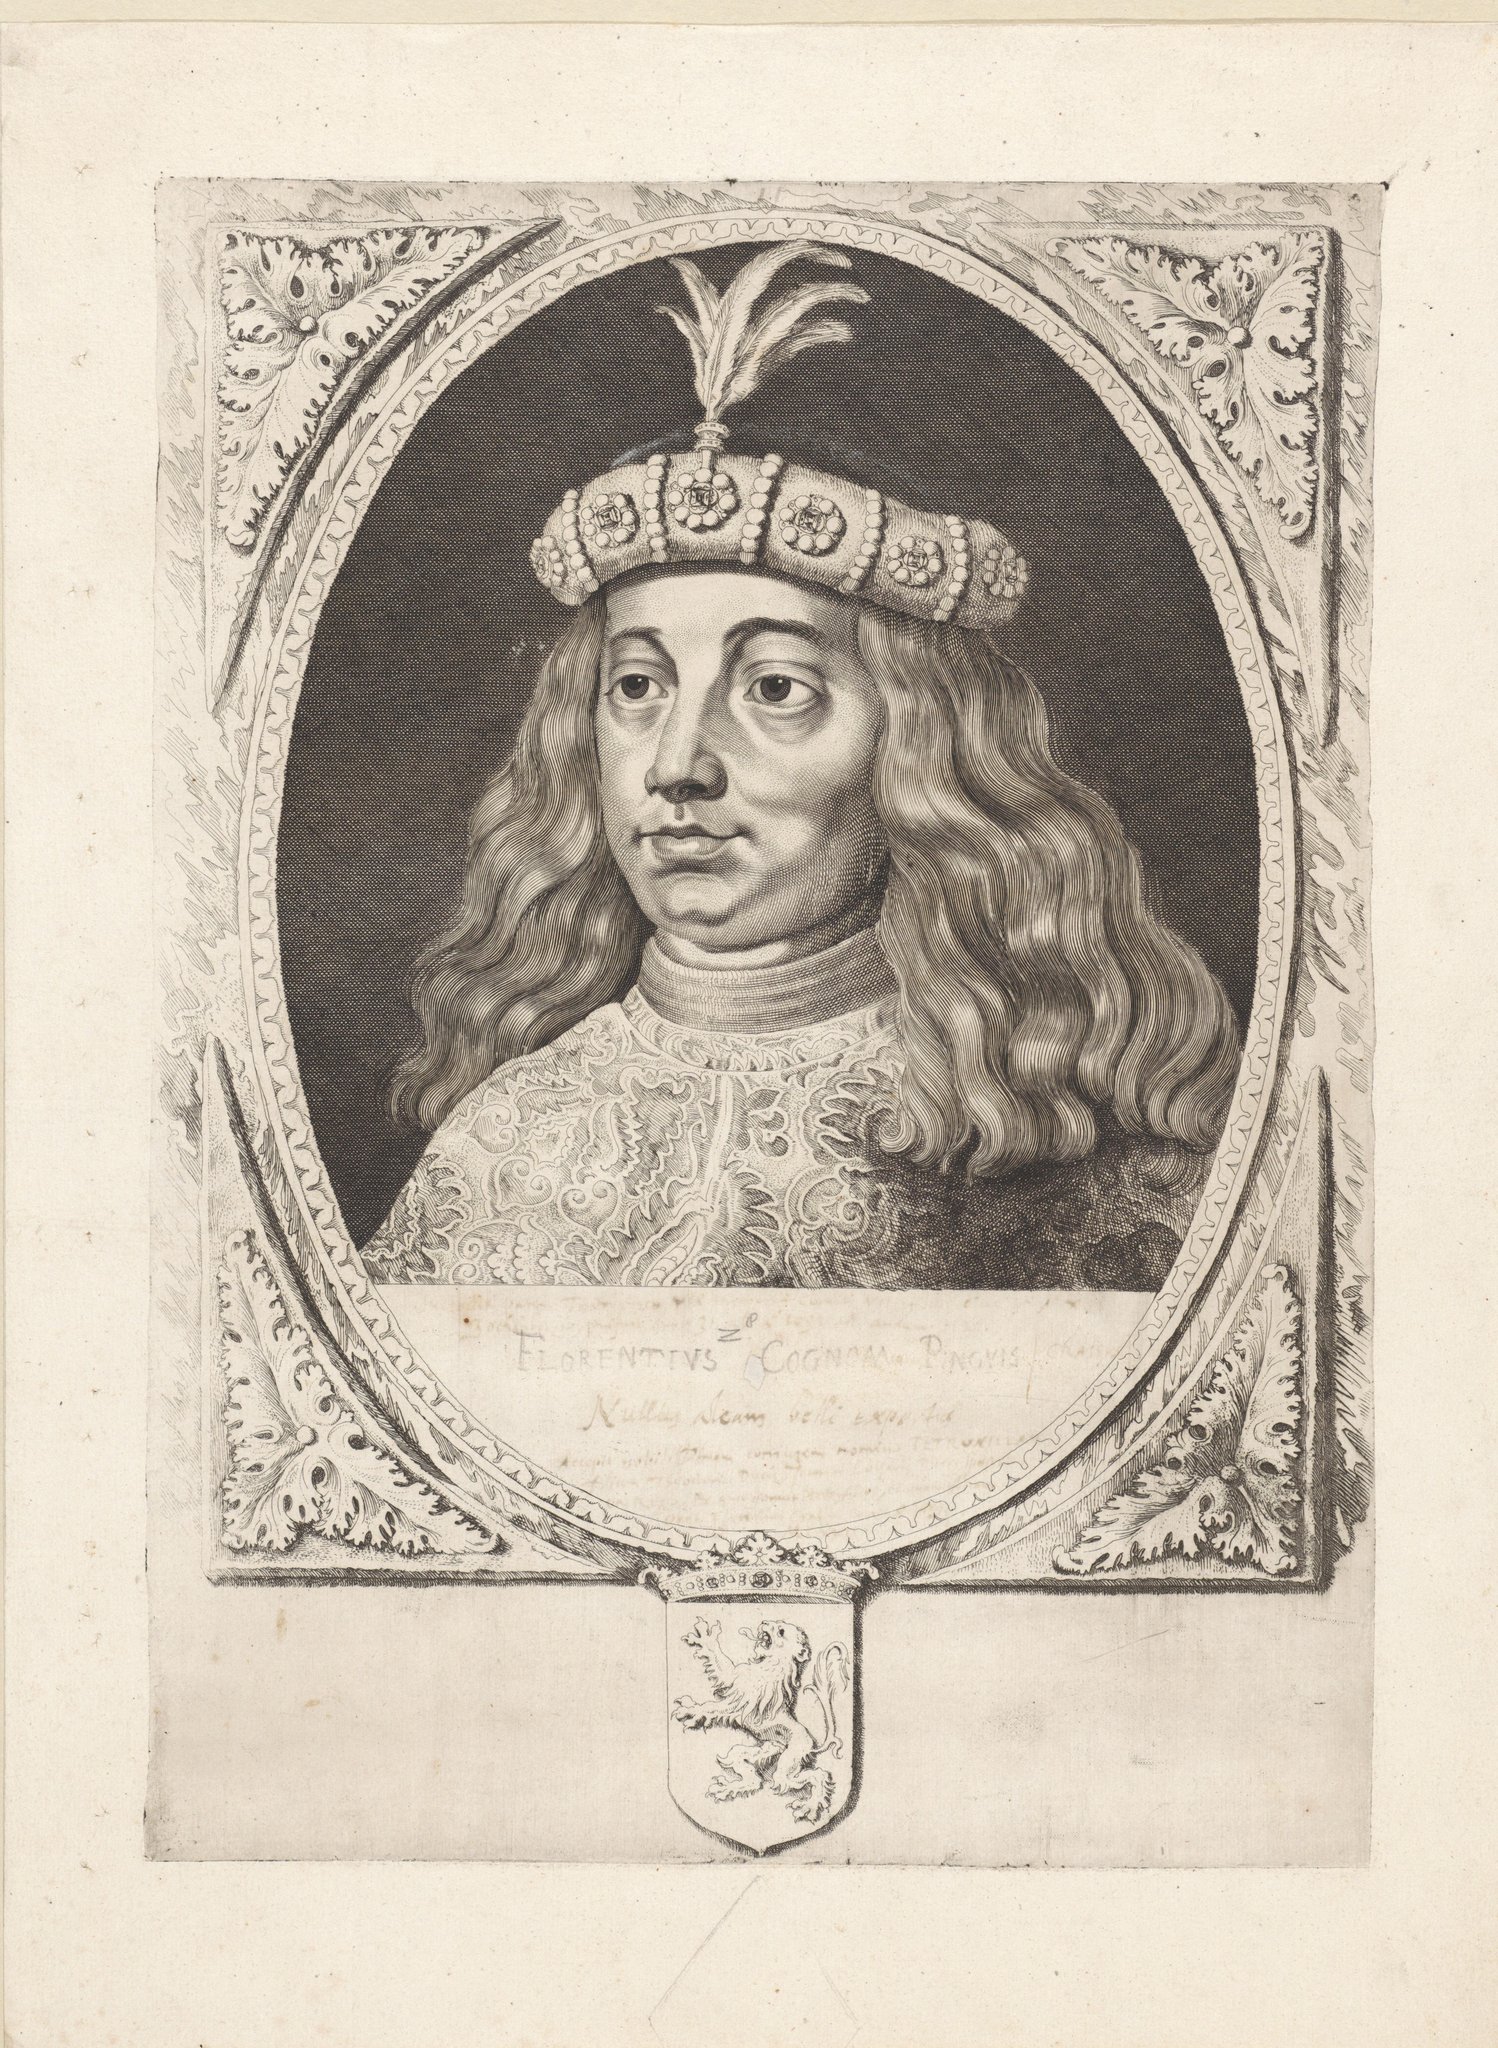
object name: print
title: Portret van Floris II, graaf van Holland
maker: cornelis visscher (ii)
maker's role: draughtsman, painter, print maker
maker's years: 1628-1658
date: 1650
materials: paper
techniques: engraving, etching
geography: haarlem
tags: floris ii (count of holland), head-gear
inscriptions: collector's mark: Lugt 240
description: Floris II, graaf van Holland, met een met parels en edelstenen verfraaide hoofddeksel. De omlijsting is versierd met het wapen van Holland.